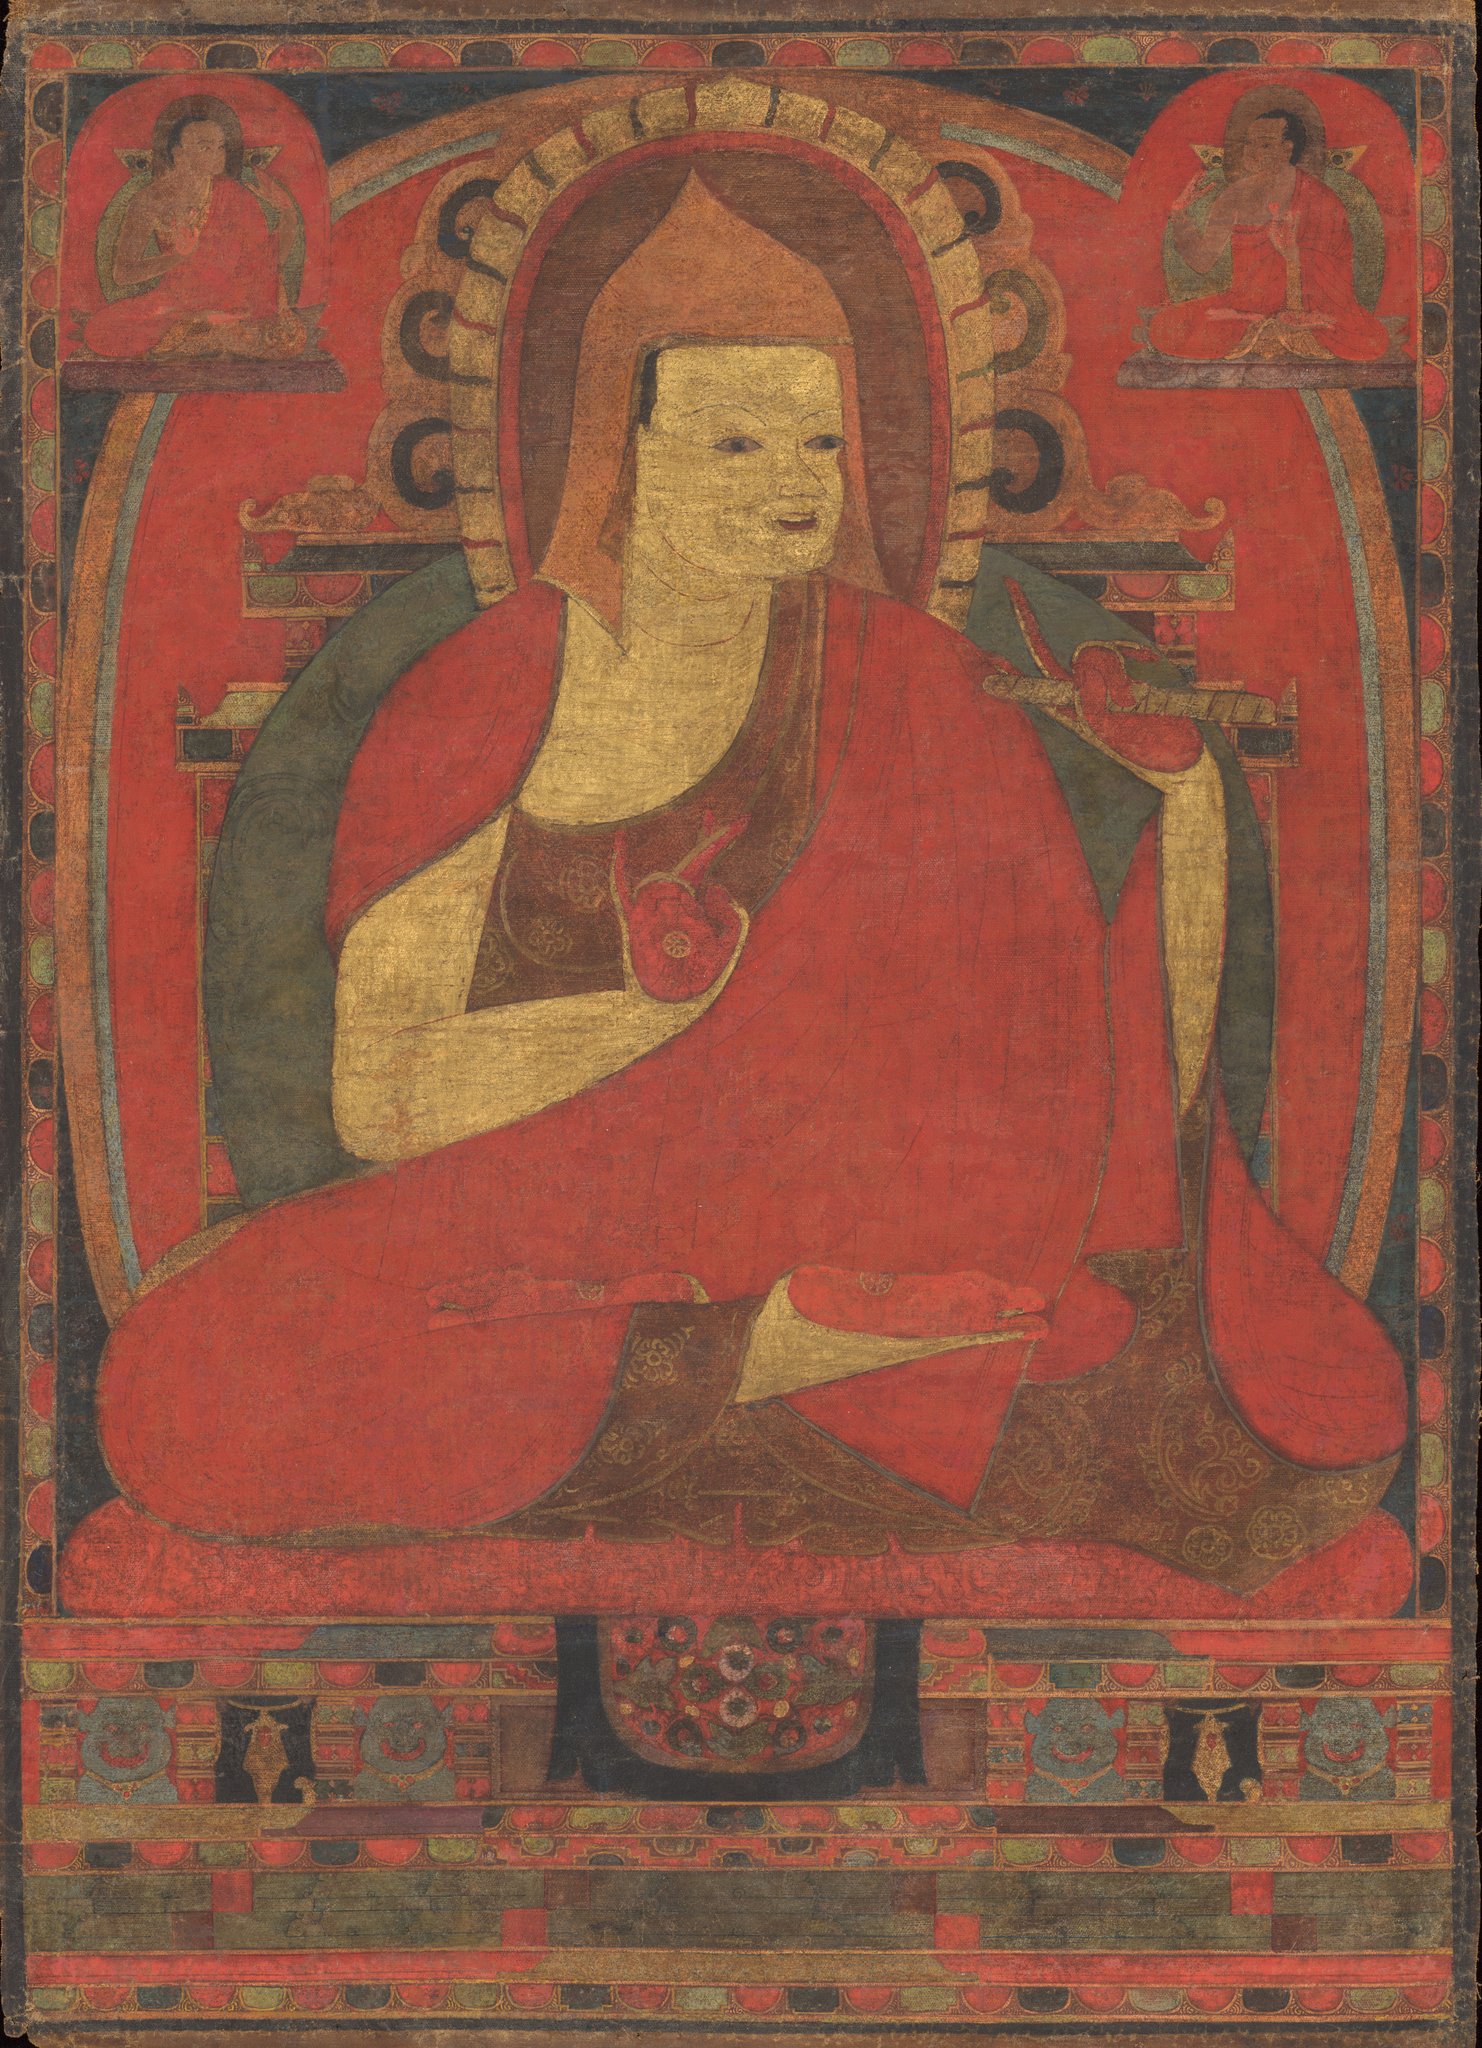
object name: thangka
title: Portrait of the Indian Monk Atisha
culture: tibetan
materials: textile, gold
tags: men,portraits,buddhism,monks